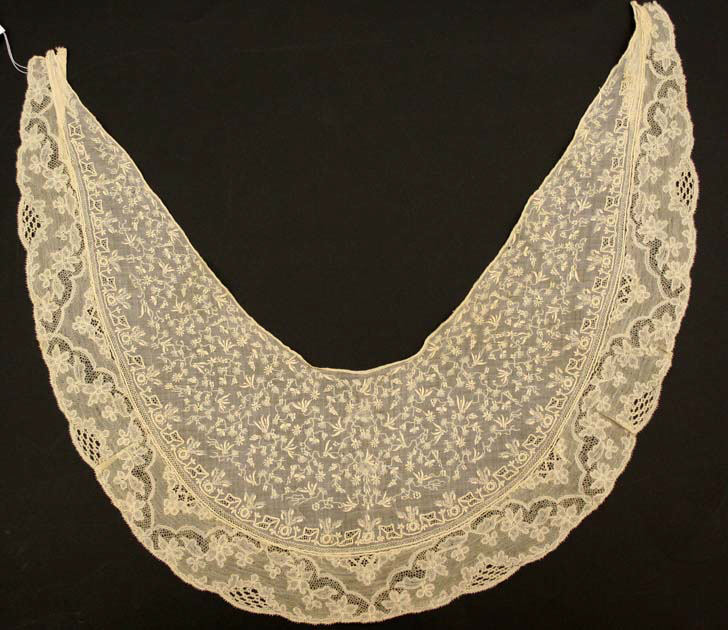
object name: collar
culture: american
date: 1801-1900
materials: cotton